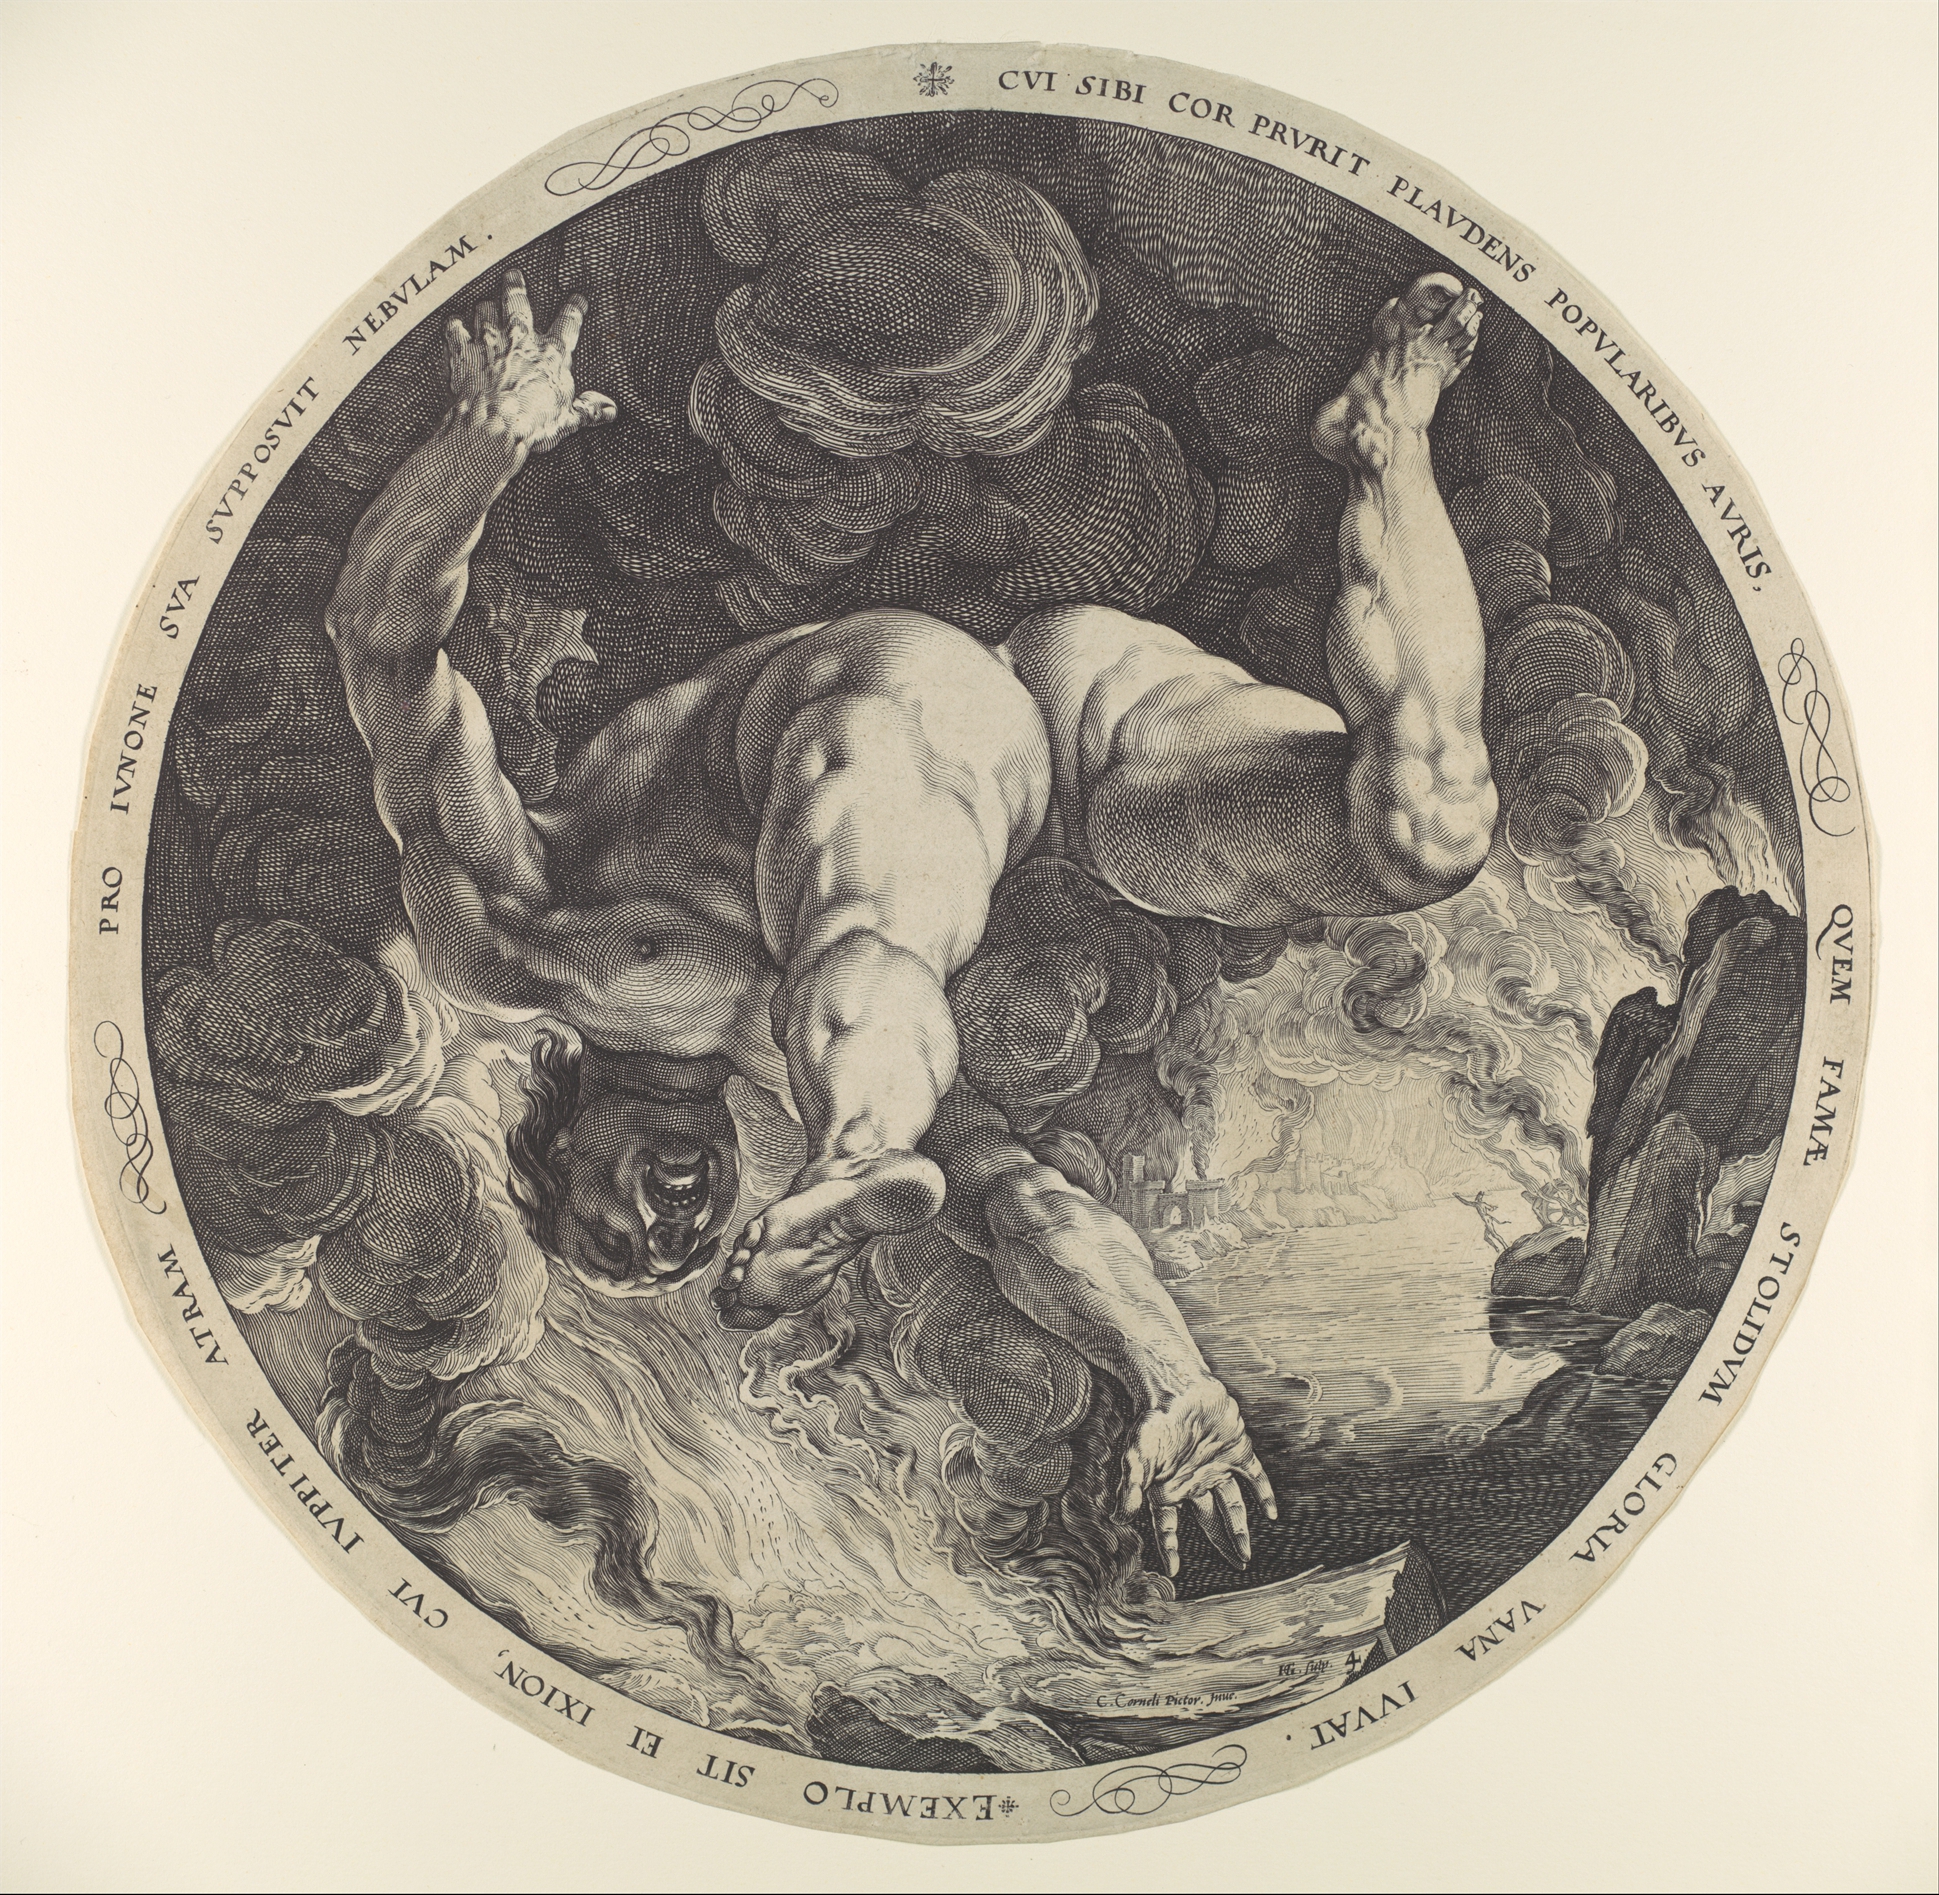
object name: print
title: Ixion, from "The Four Disgracers"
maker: hendrick goltzius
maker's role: artist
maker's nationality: netherlandish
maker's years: 1558-1617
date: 1588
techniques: engraving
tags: male nudes